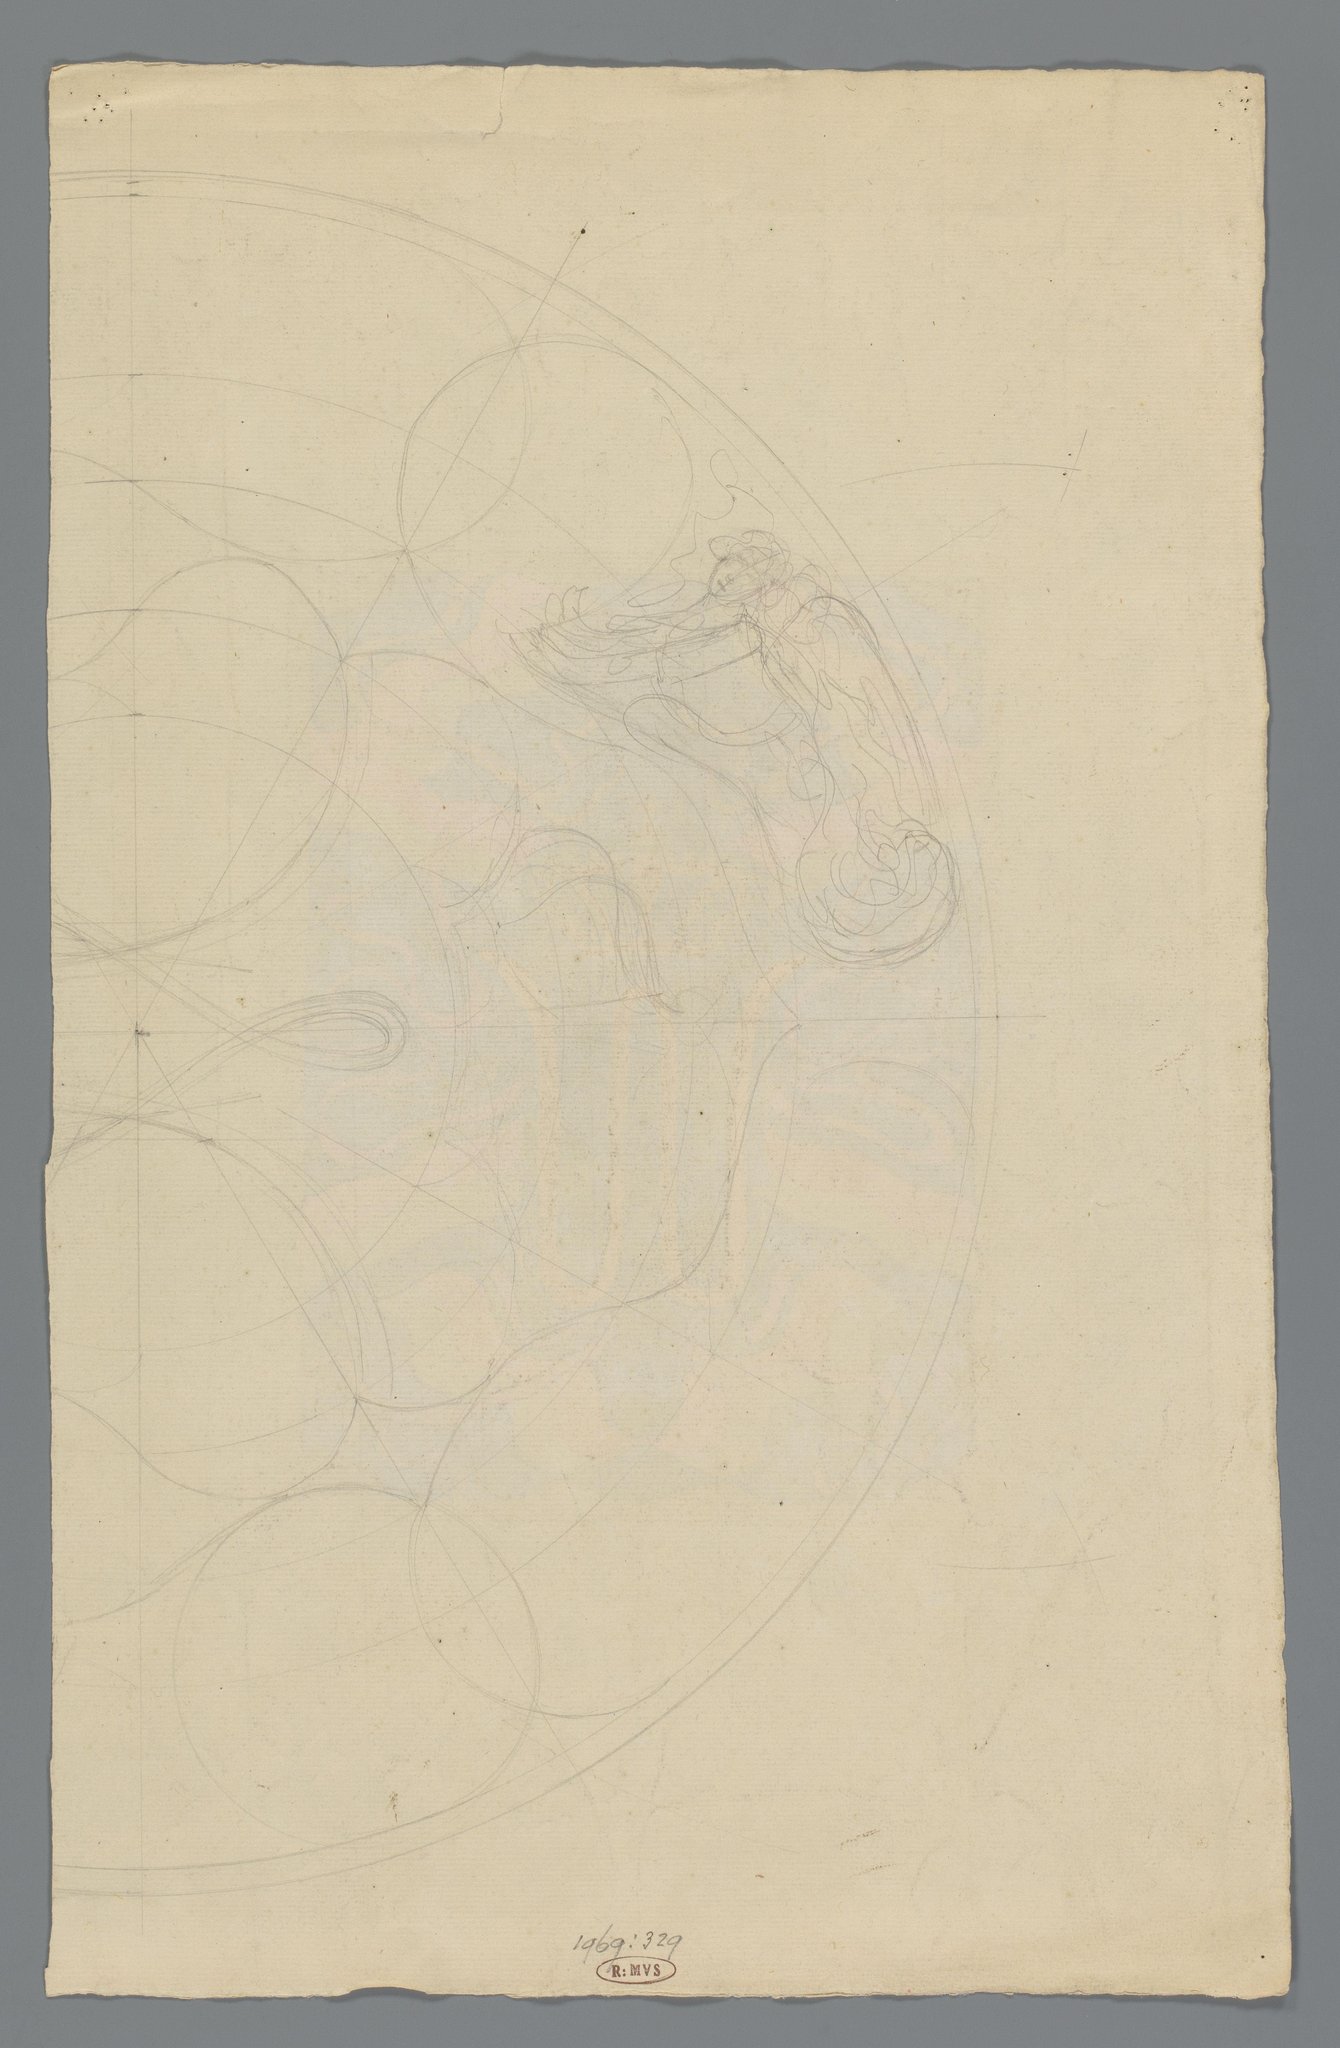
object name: design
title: Ontwerp voor inhuldigingsbord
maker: carel adolph lion cachet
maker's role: draughtsman, print maker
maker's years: 1864-1945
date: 1939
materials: paper, pencil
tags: dish, plate, saucer, installation of a ruler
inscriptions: date: ‘1939’